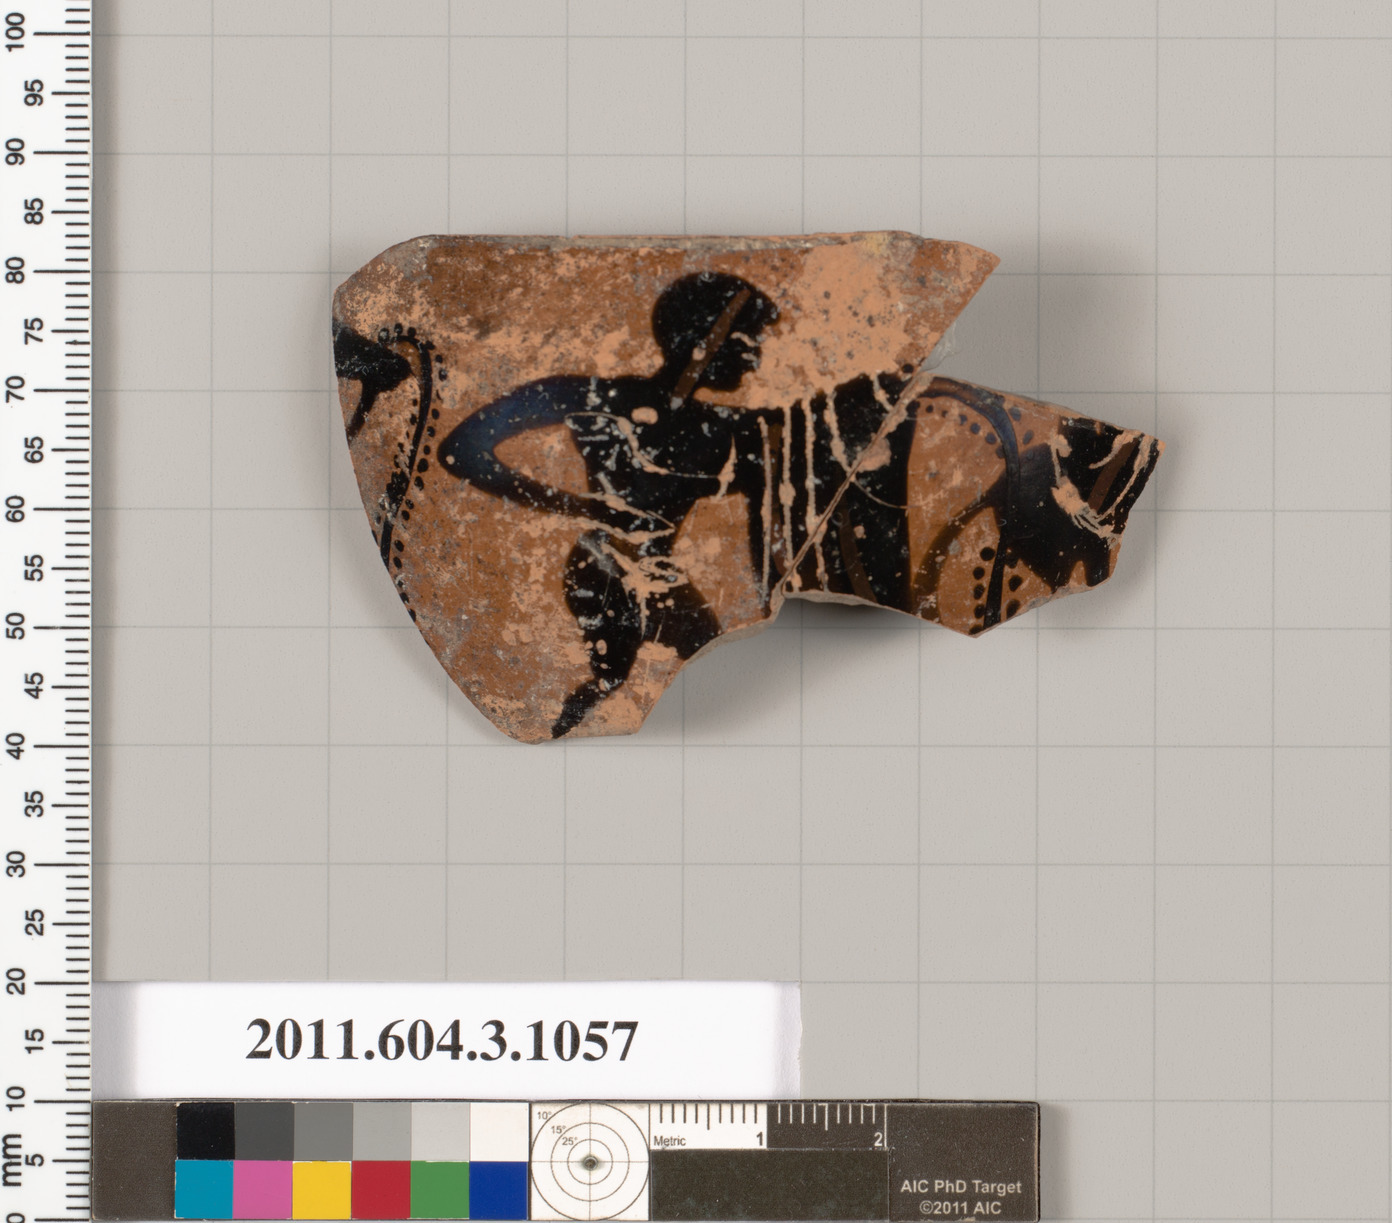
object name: mastoid fragment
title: Terracotta fragment of a mastoid (drinking cup with narrow base)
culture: greek, attic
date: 534-468 BCE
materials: terracotta